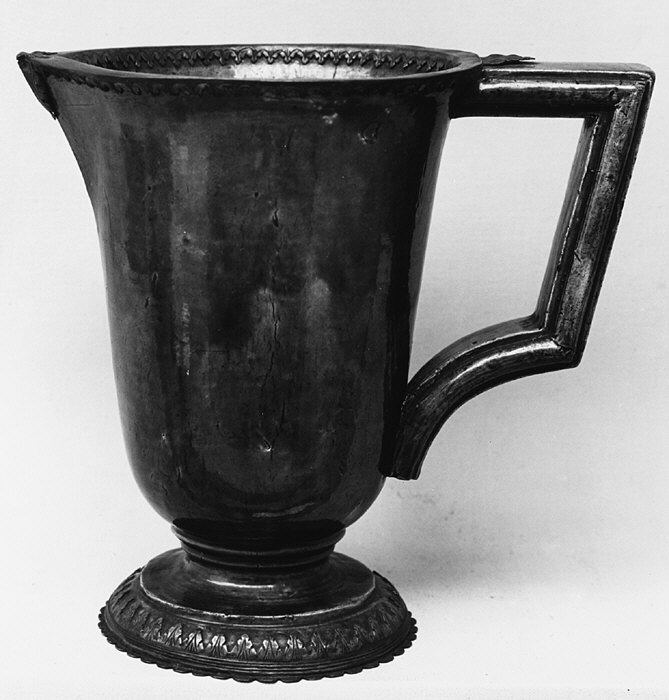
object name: ewer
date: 1567-1633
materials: earthenware, silver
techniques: glazing